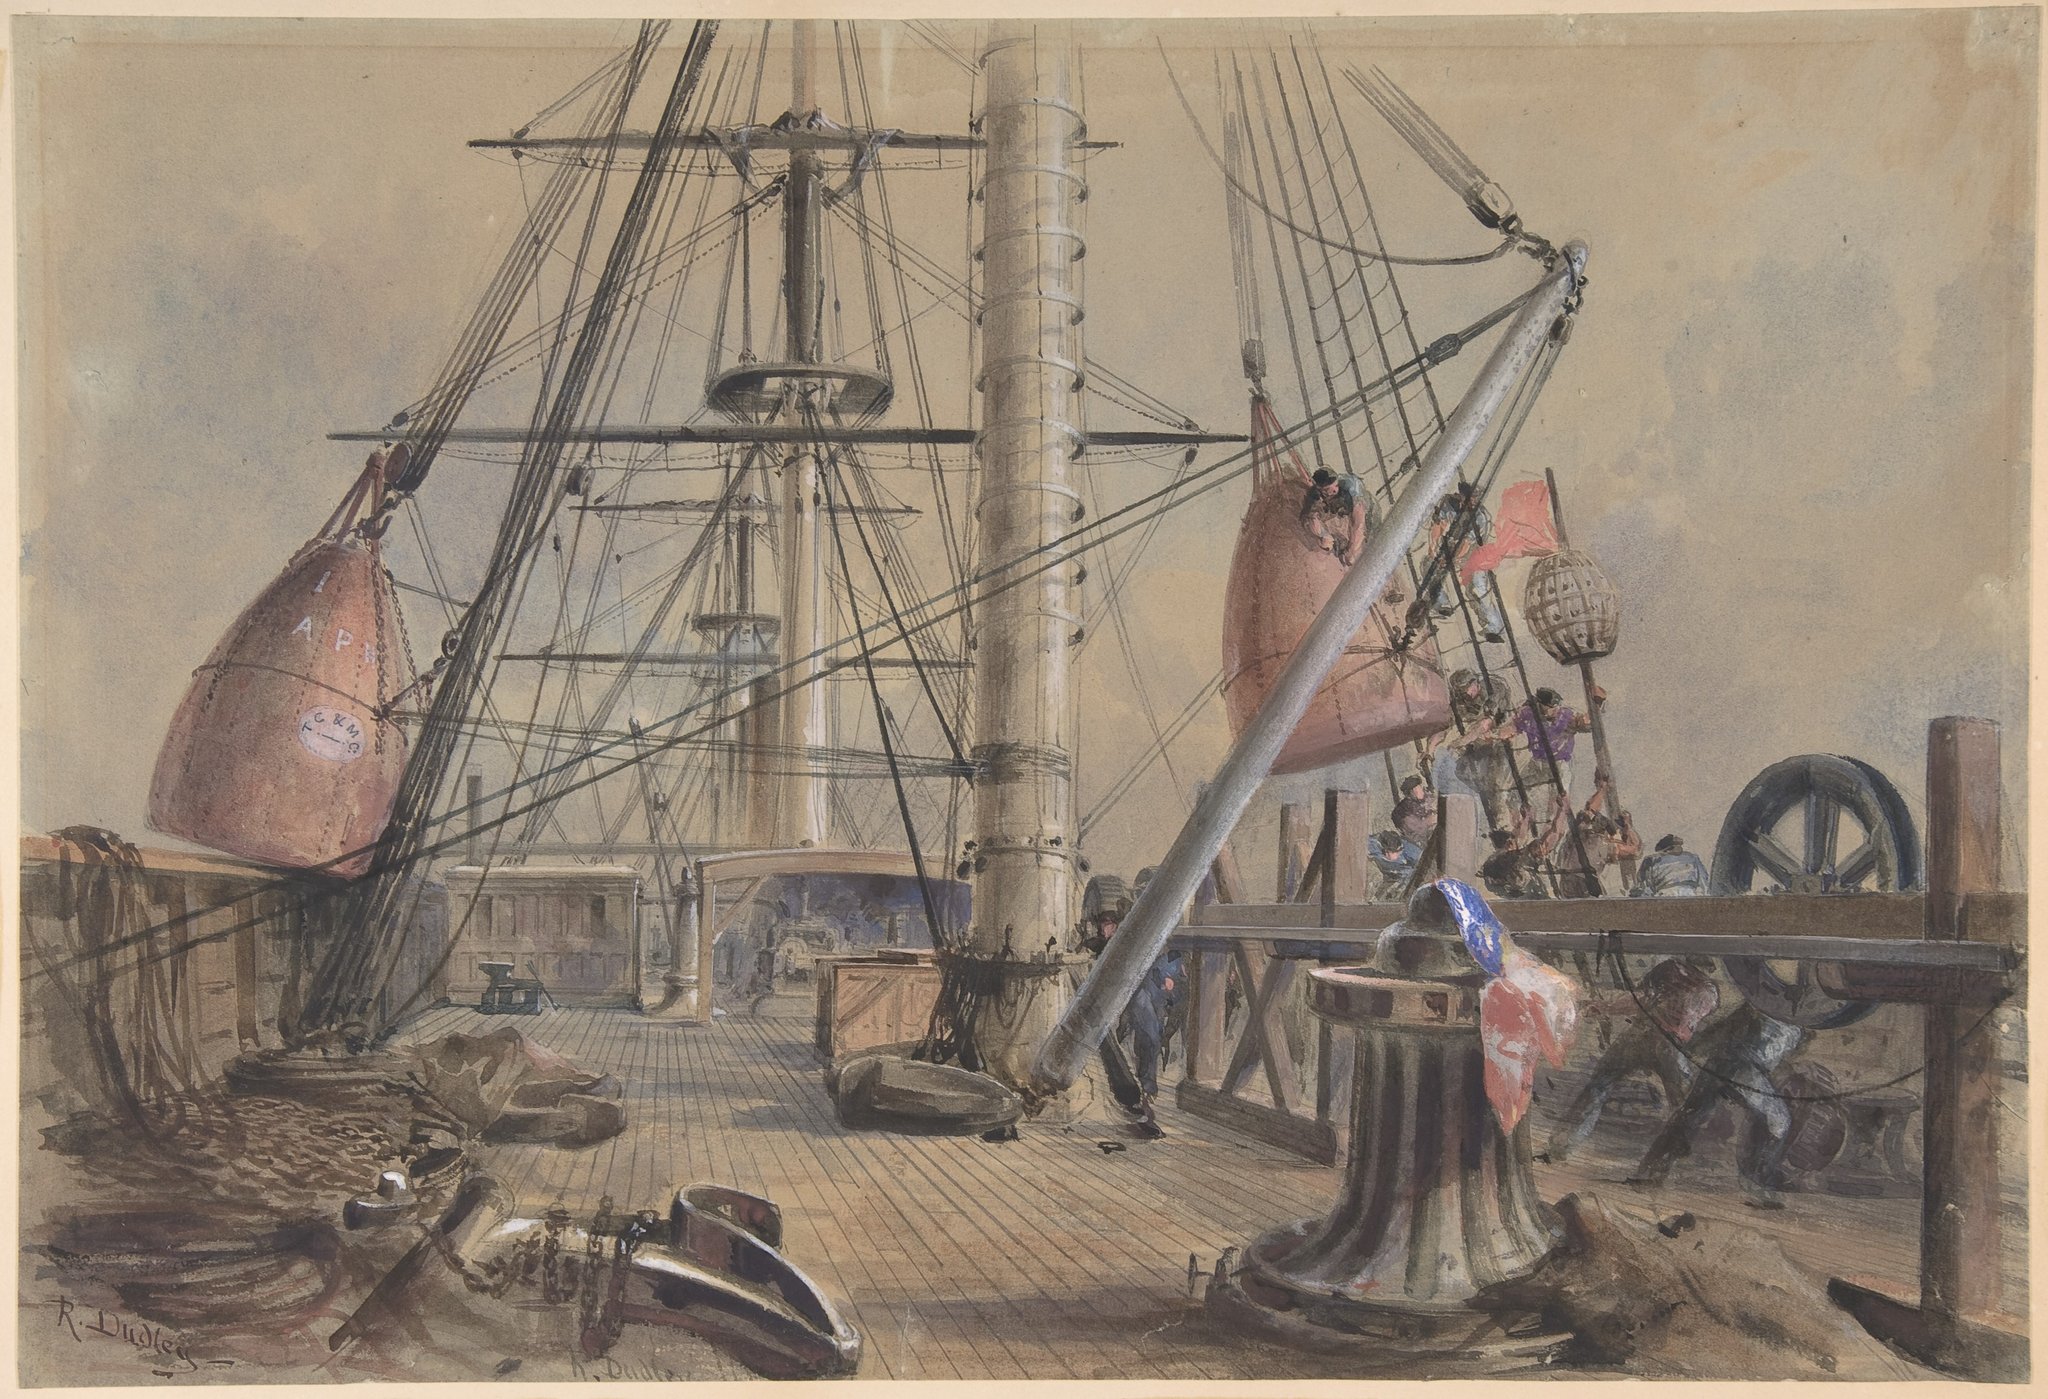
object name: drawing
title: Getting Out One of the Great Buoys: The Deck of the Great Eastern Looking From the Forecastle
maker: robert charles dudley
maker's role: artist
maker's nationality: british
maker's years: 1826-1909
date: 1865-1866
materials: gouache, graphite, watercolor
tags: ships,transatlantic cable